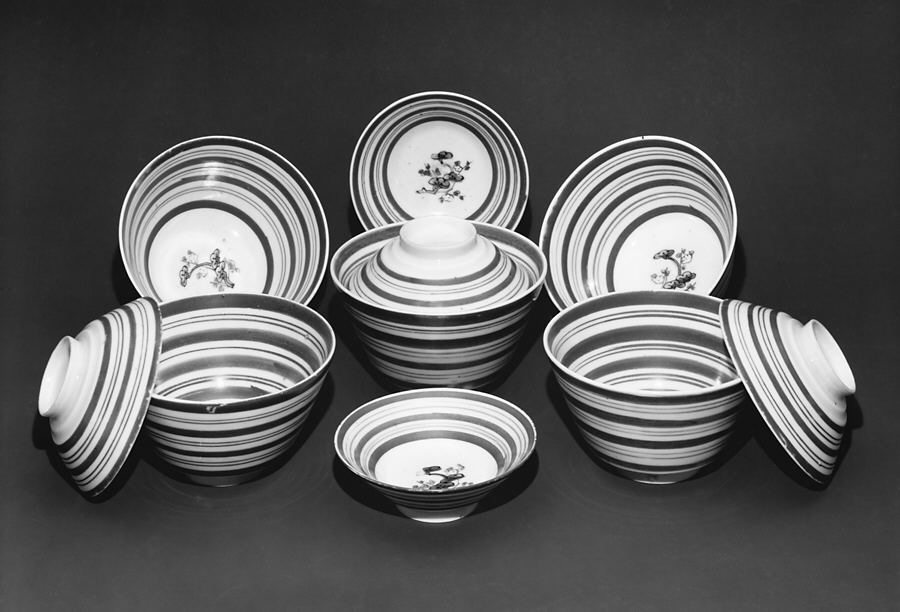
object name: covered bowl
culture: japanese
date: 1701-1800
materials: porcelain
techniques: underglaze